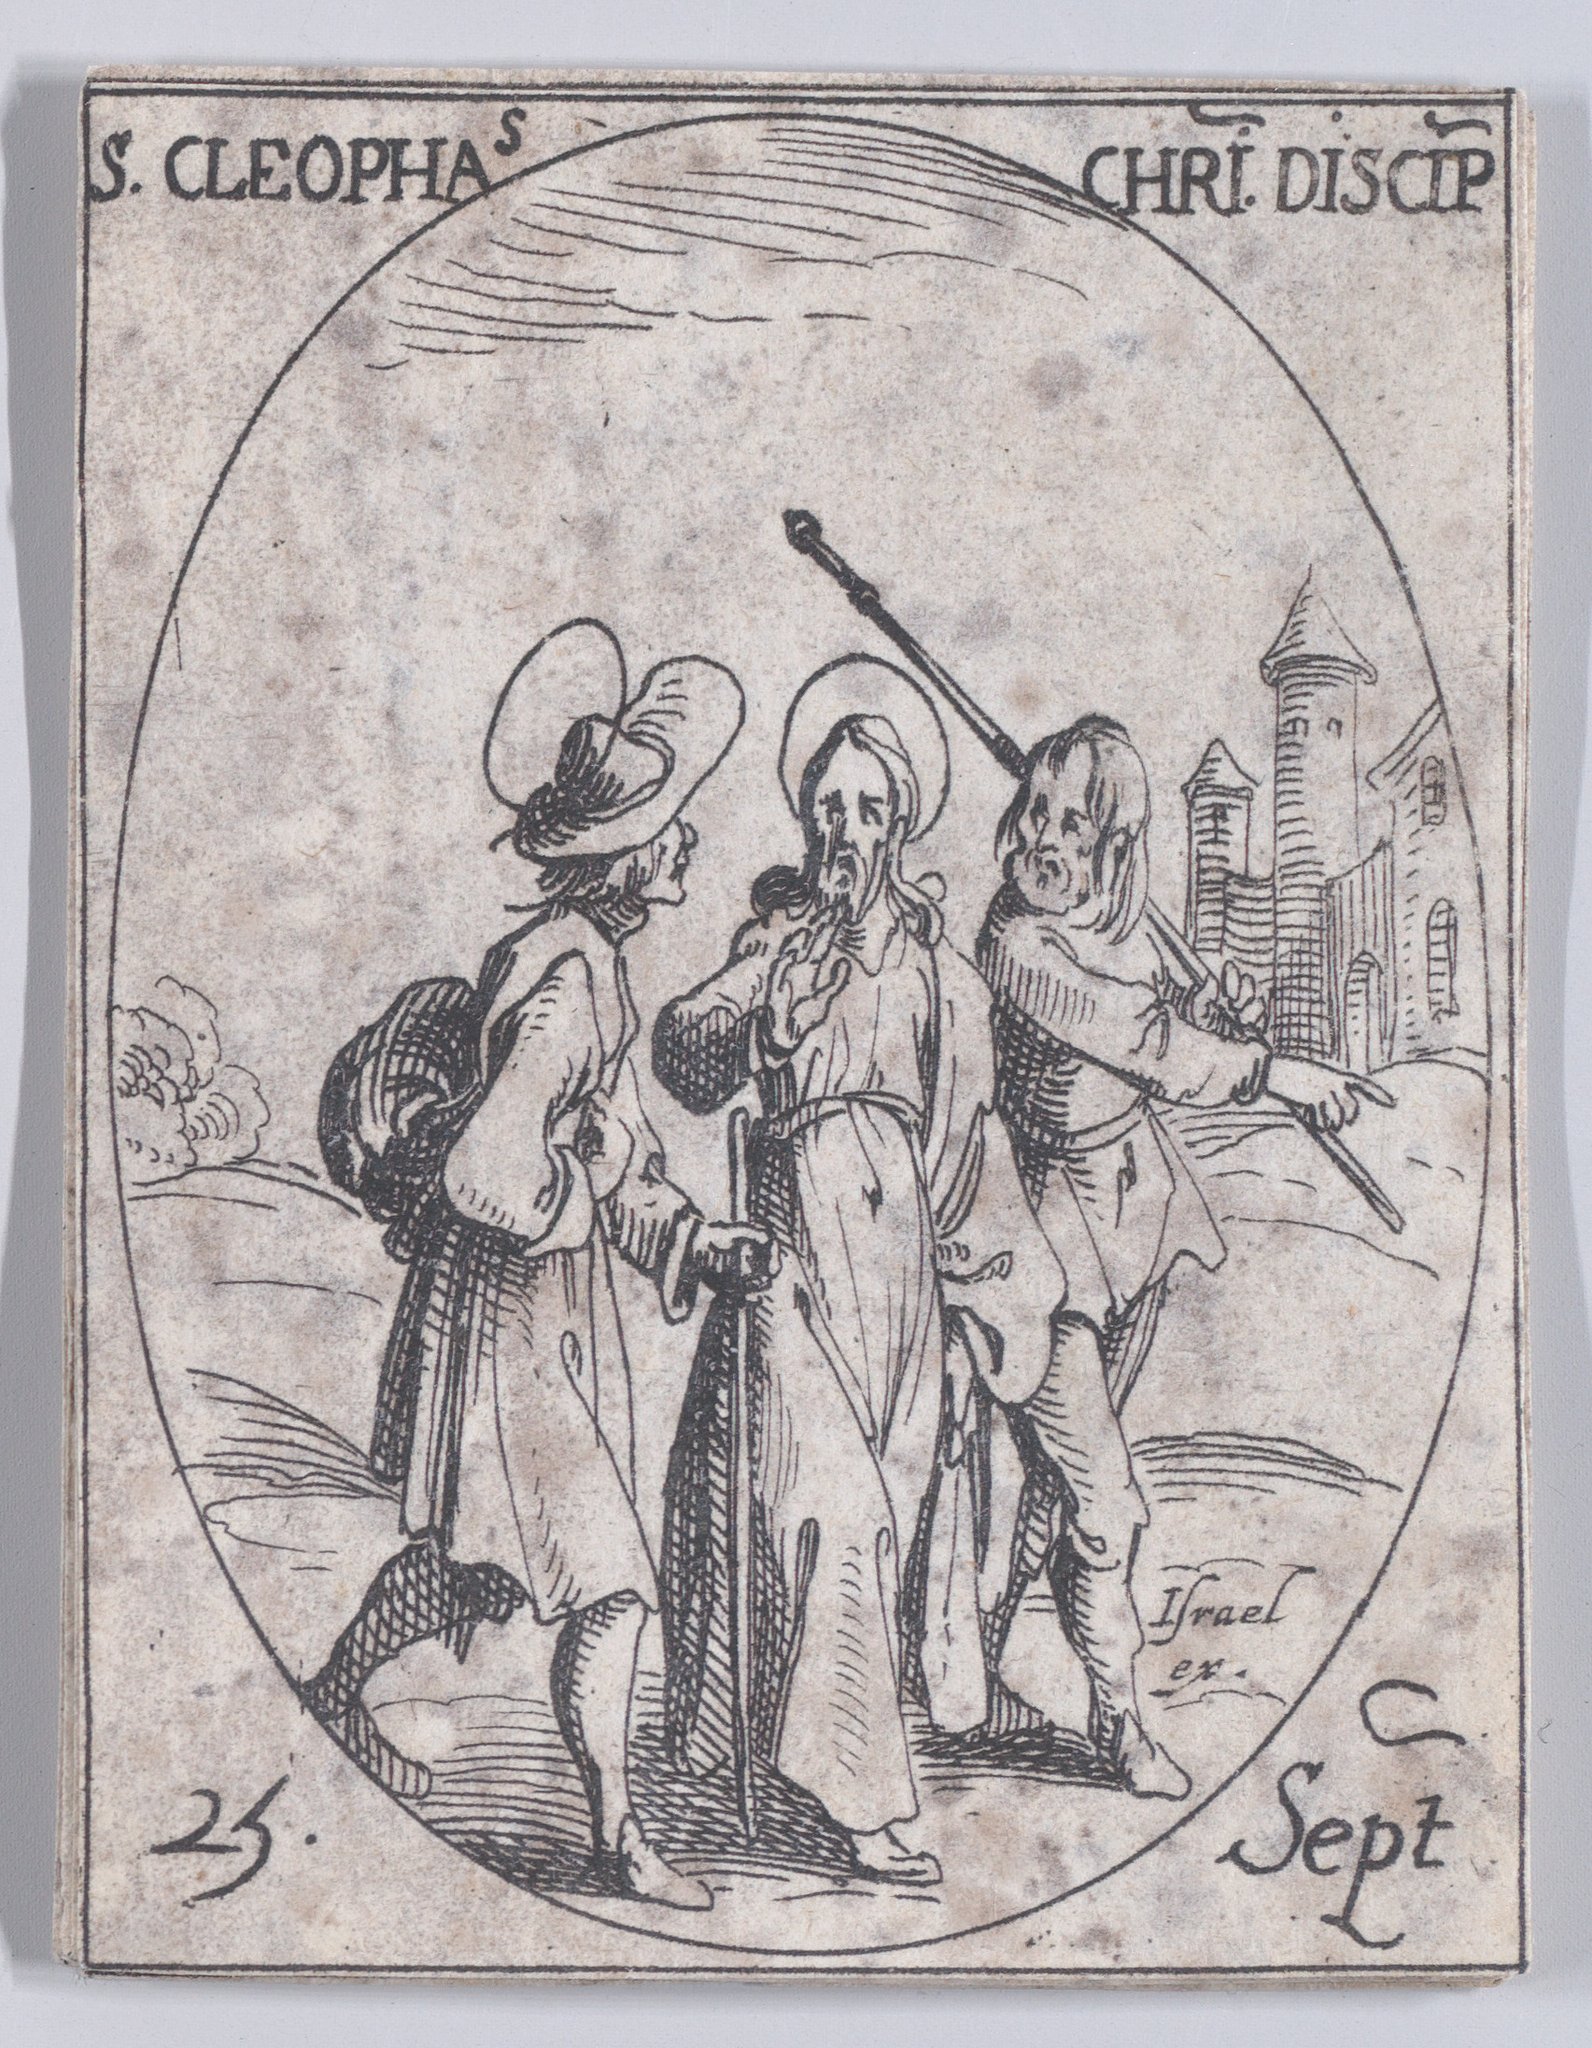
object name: print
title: S. Cléophas, Disciple du Christ (St. Cleophas, Disciple of Christ), September 25th, from "Les Images De Tous Les Saincts et Saintes de L'Année" (Images of All of the Saints and Religious Events of the Year)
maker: jacques callot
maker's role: artist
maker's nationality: french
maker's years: 1592-1635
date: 1636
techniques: etching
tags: men,saints